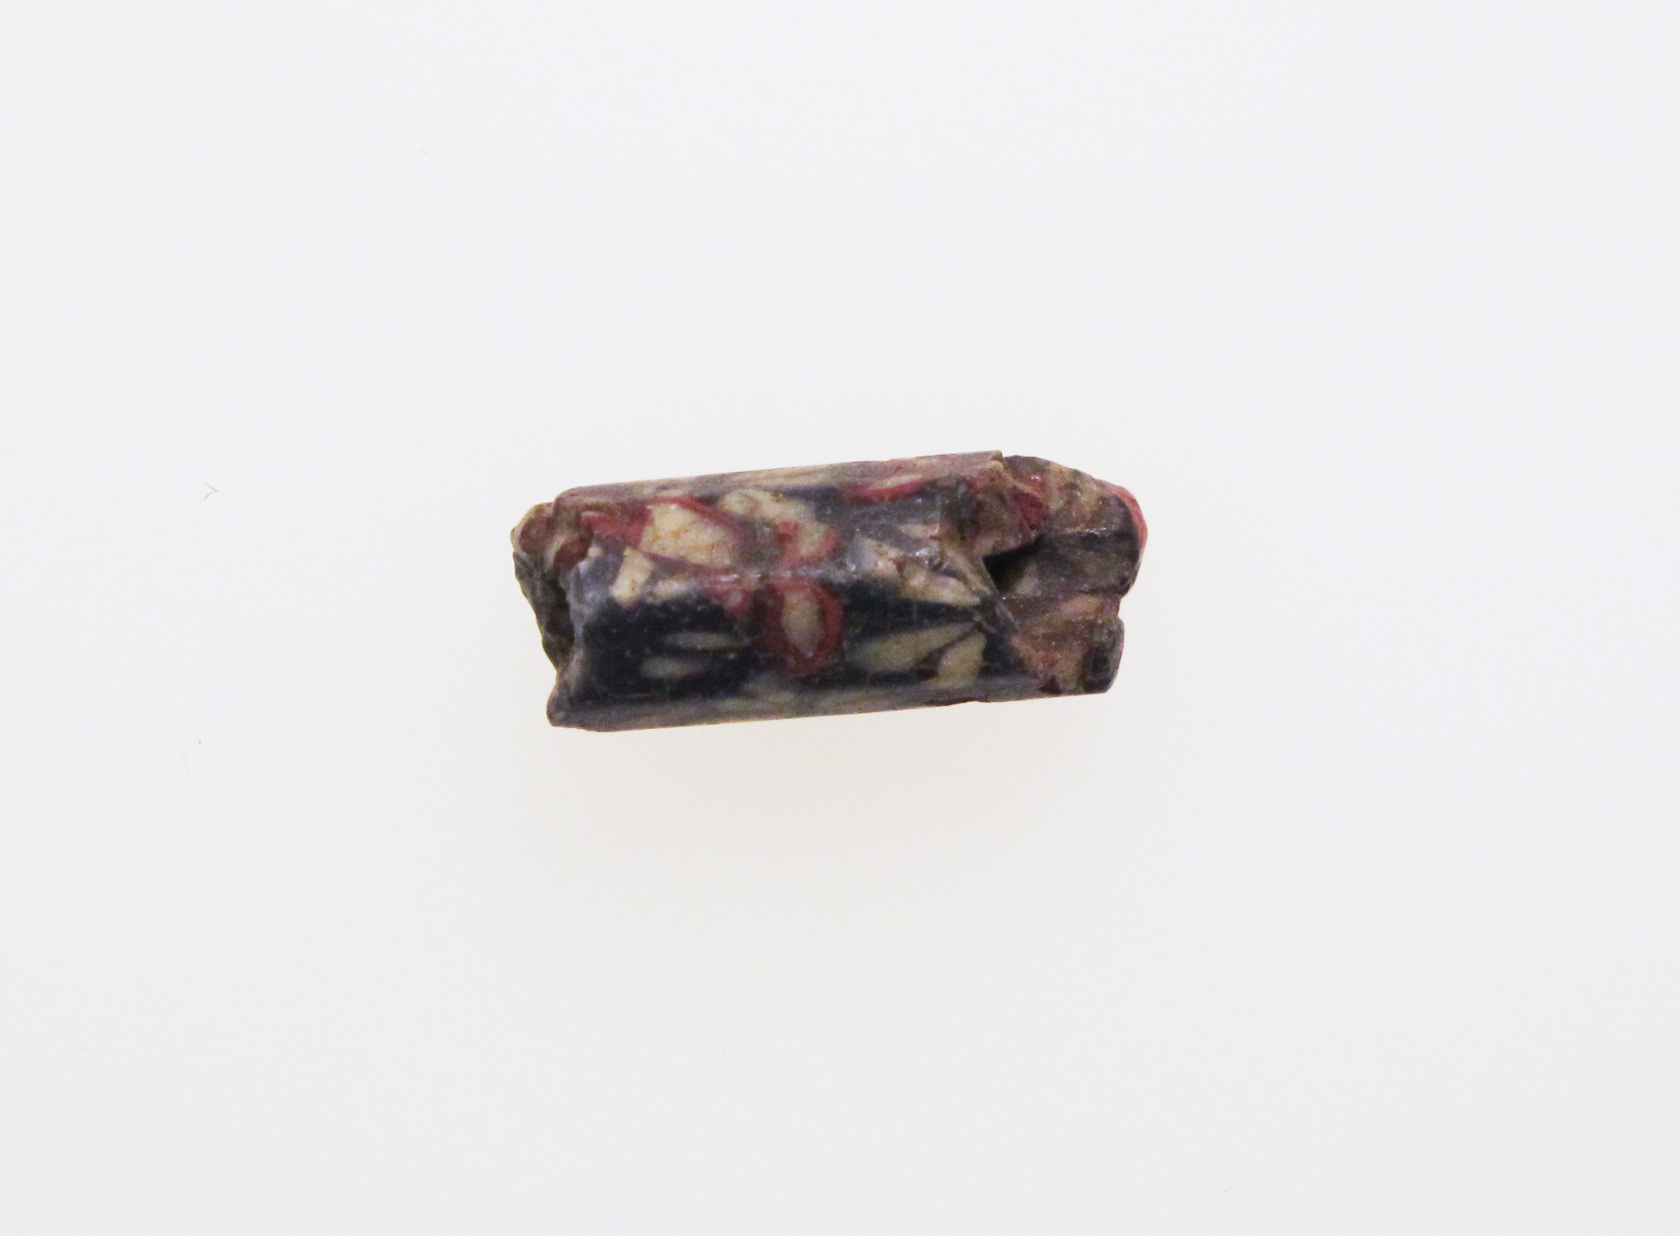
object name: millefiori bead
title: Glass mosaic bead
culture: roman, egyptian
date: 201-400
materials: glass